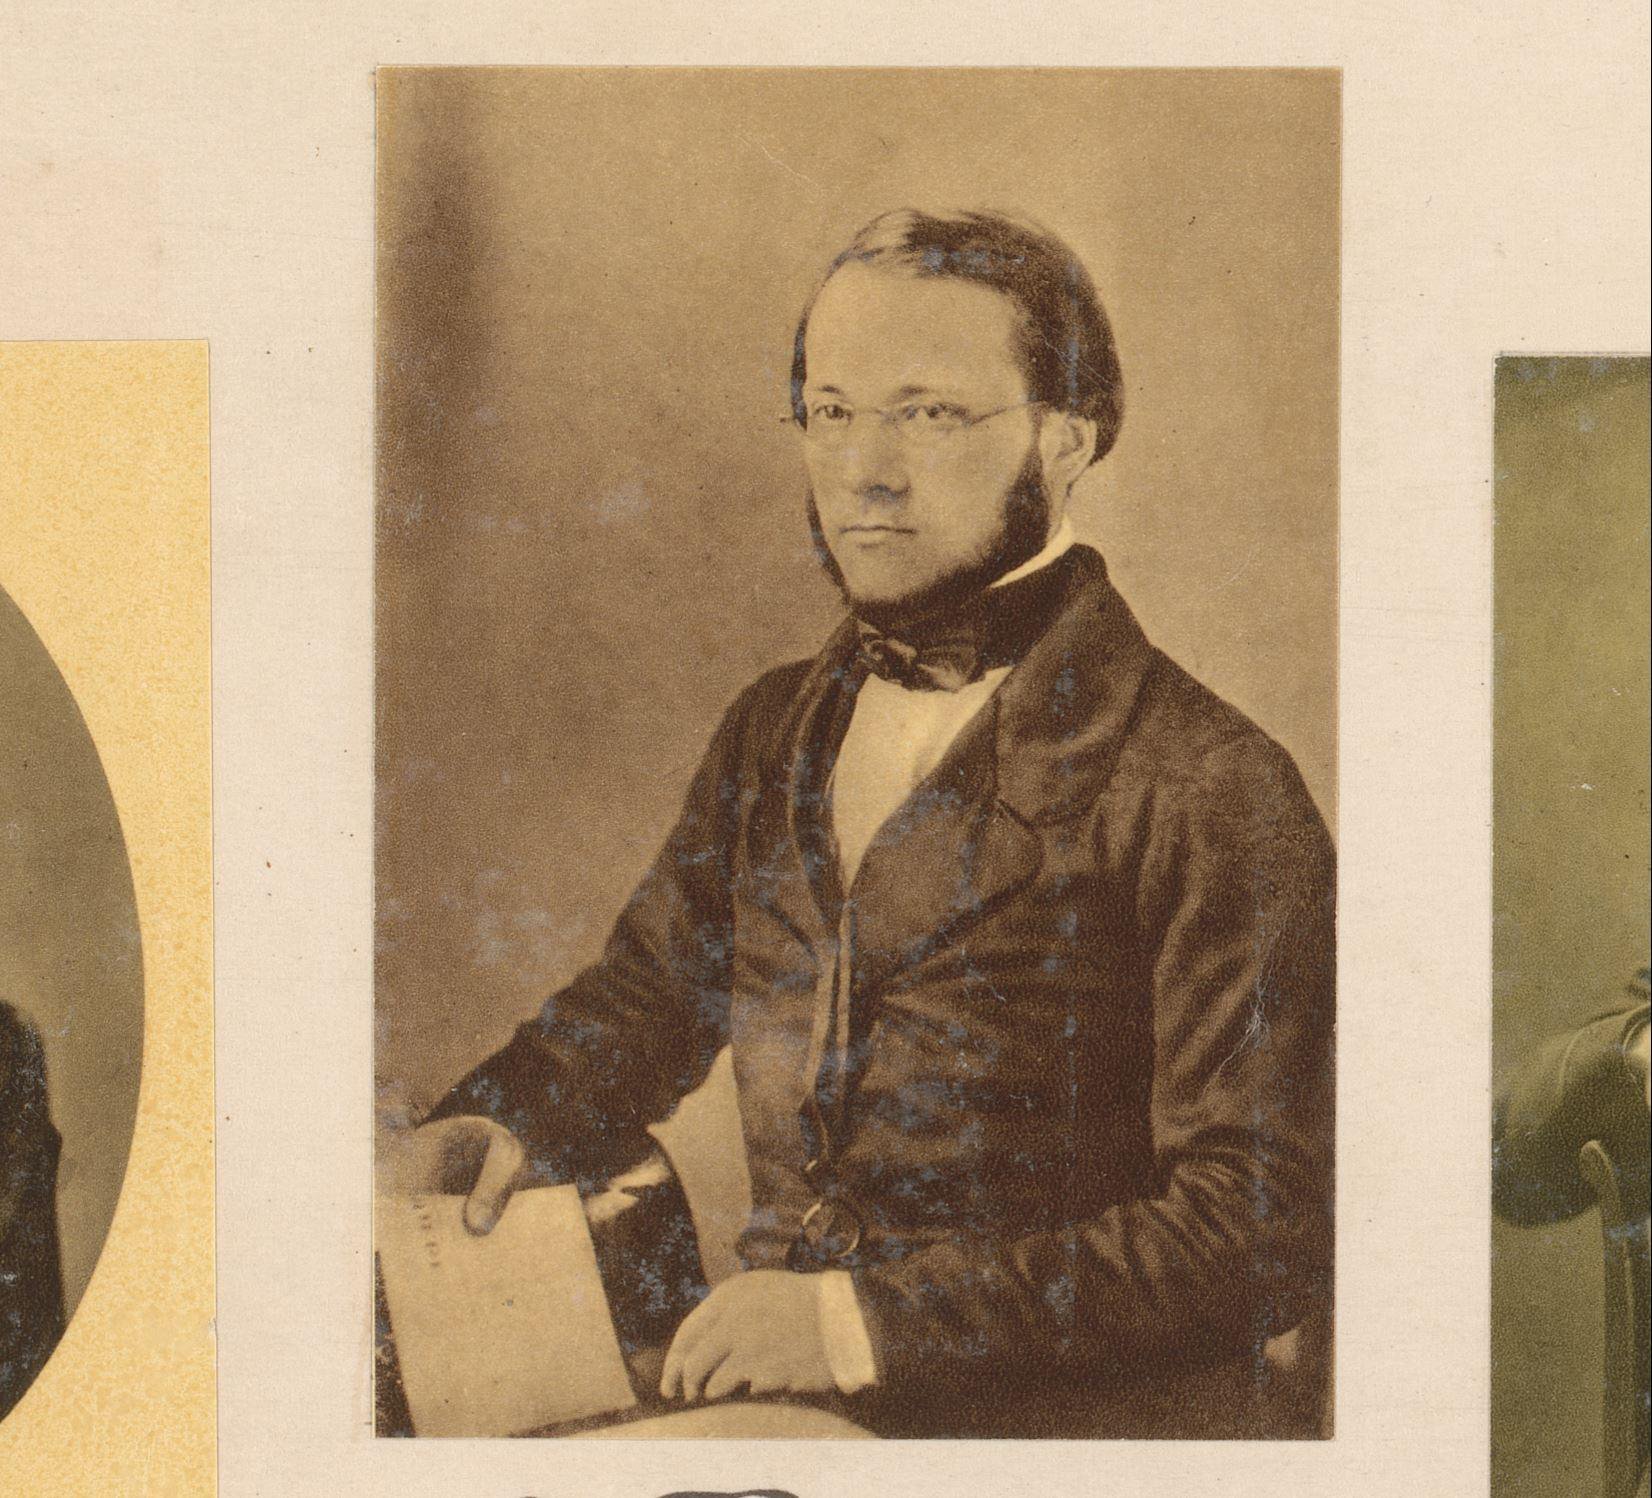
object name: album leaf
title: Portret van Louis Pasteur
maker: Anonymous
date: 1852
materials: paper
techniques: rotogravure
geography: france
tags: historical persons, science and technology (+ portrait of scholar, scientist), france